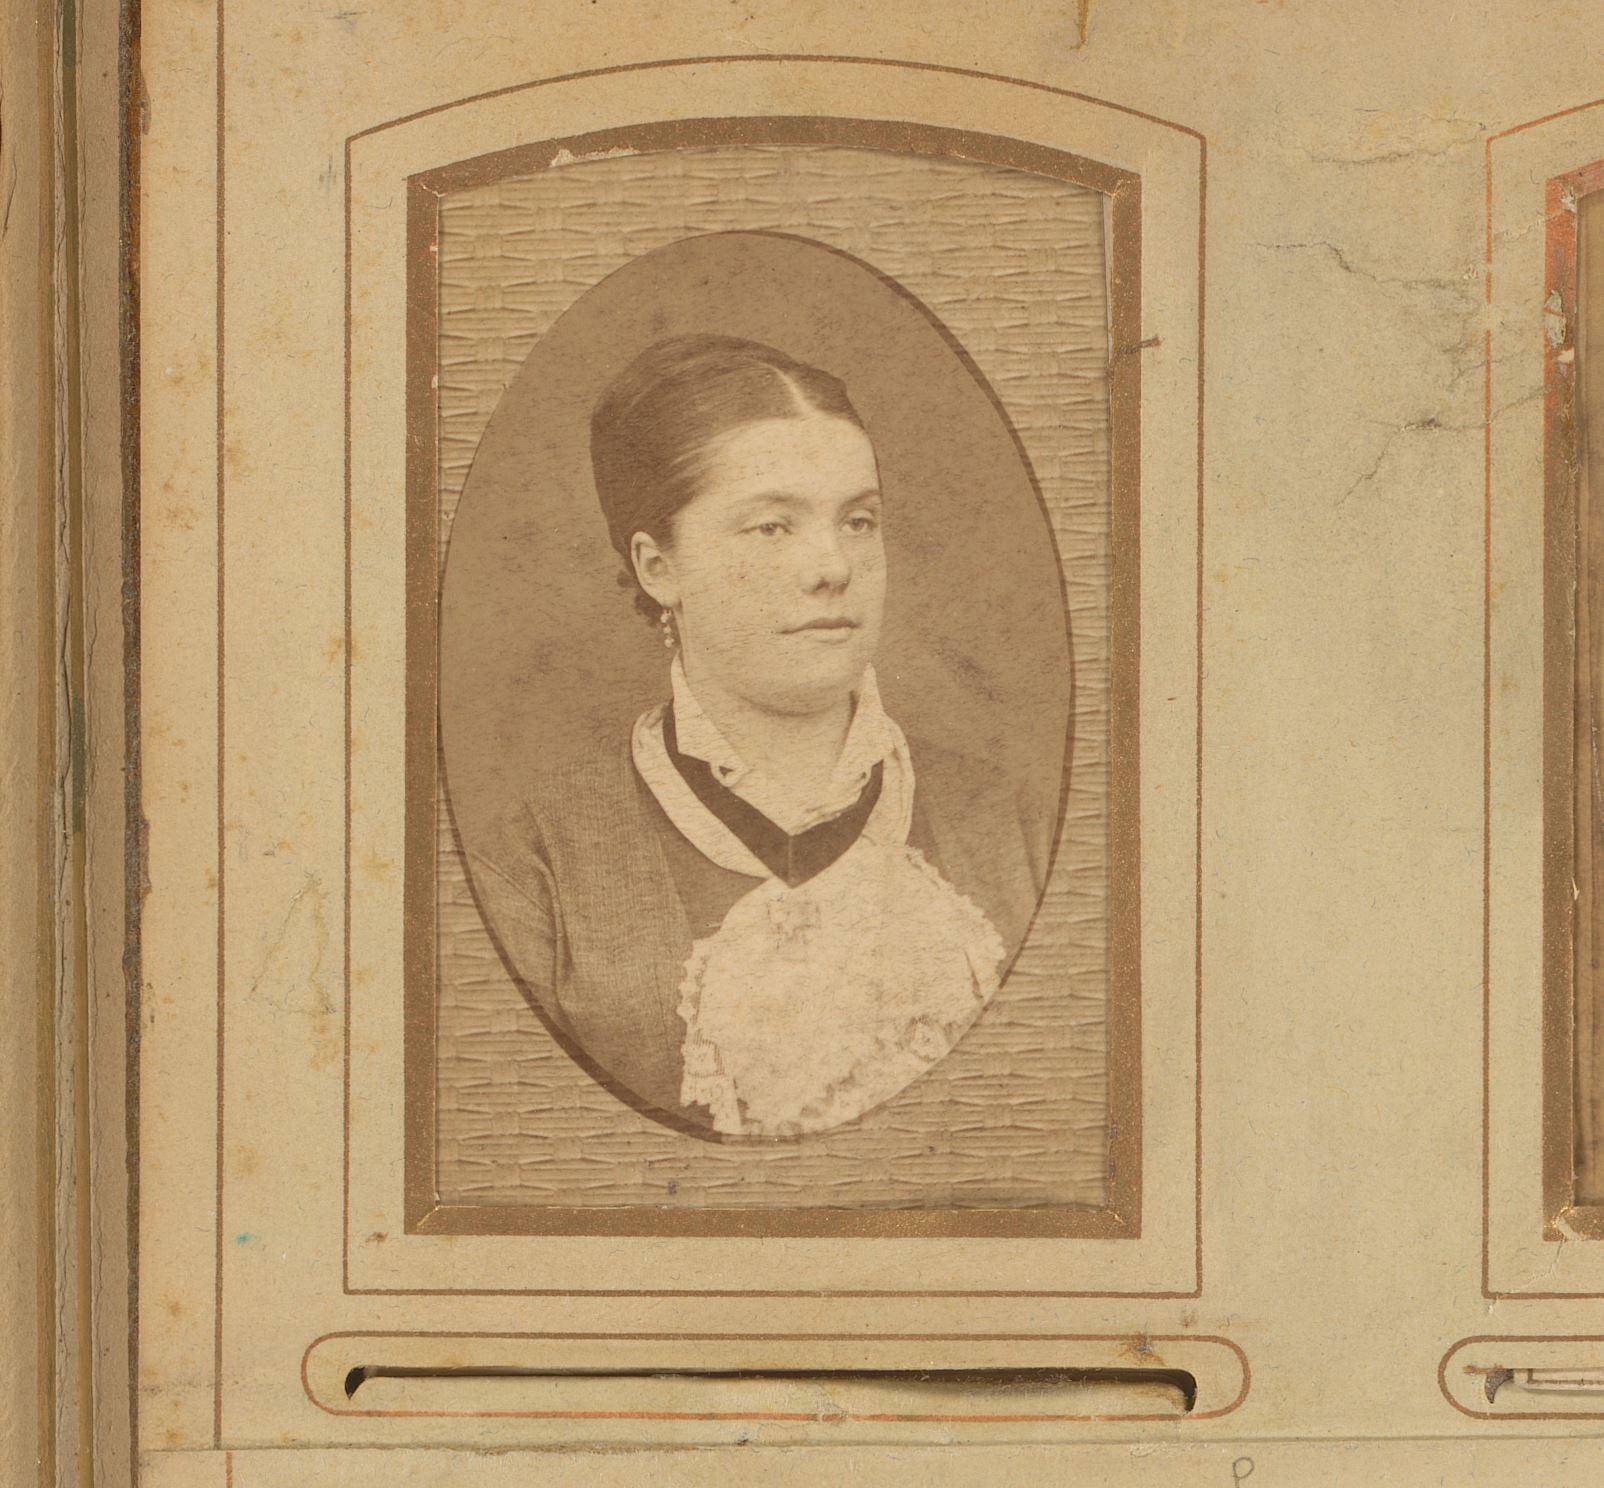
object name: photograph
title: Portret van een vrouw met oorbellen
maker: carl philip wollrabe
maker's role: fotograaf, musicus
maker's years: 1812-1887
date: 1864-1887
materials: cardboard, photographic support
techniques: albumen print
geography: the hague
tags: historical persons - bb - woman, ear-rings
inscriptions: inscription: ‘C.P. WOLLRABE sen./ PHOTOGRAPHE/ van/ Z.M. DEN KONING EN WIJLEN/ H.M. DE KONINGIN VAN/ ZWEDEN EN NOORWEGEN/ Boekhorststraat, 91./ 'S HAGE./ De plaat blijft tot nabestelling bewaard.’